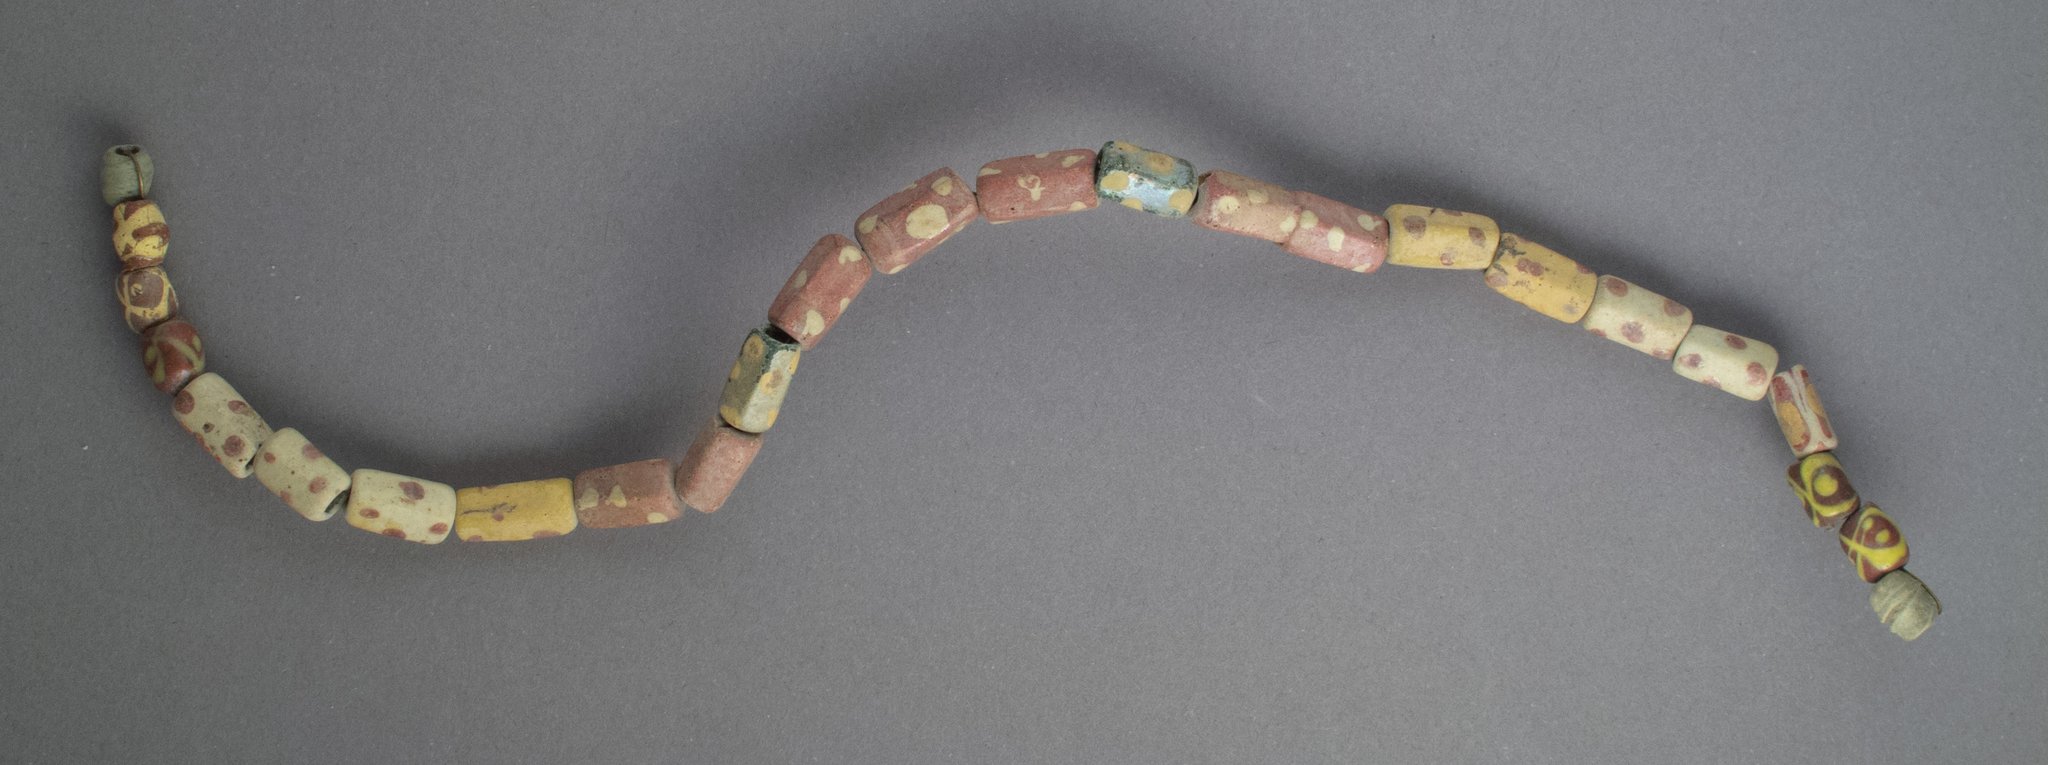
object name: bead, 25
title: Beads, 25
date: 7000 BCE-330 CE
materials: glass